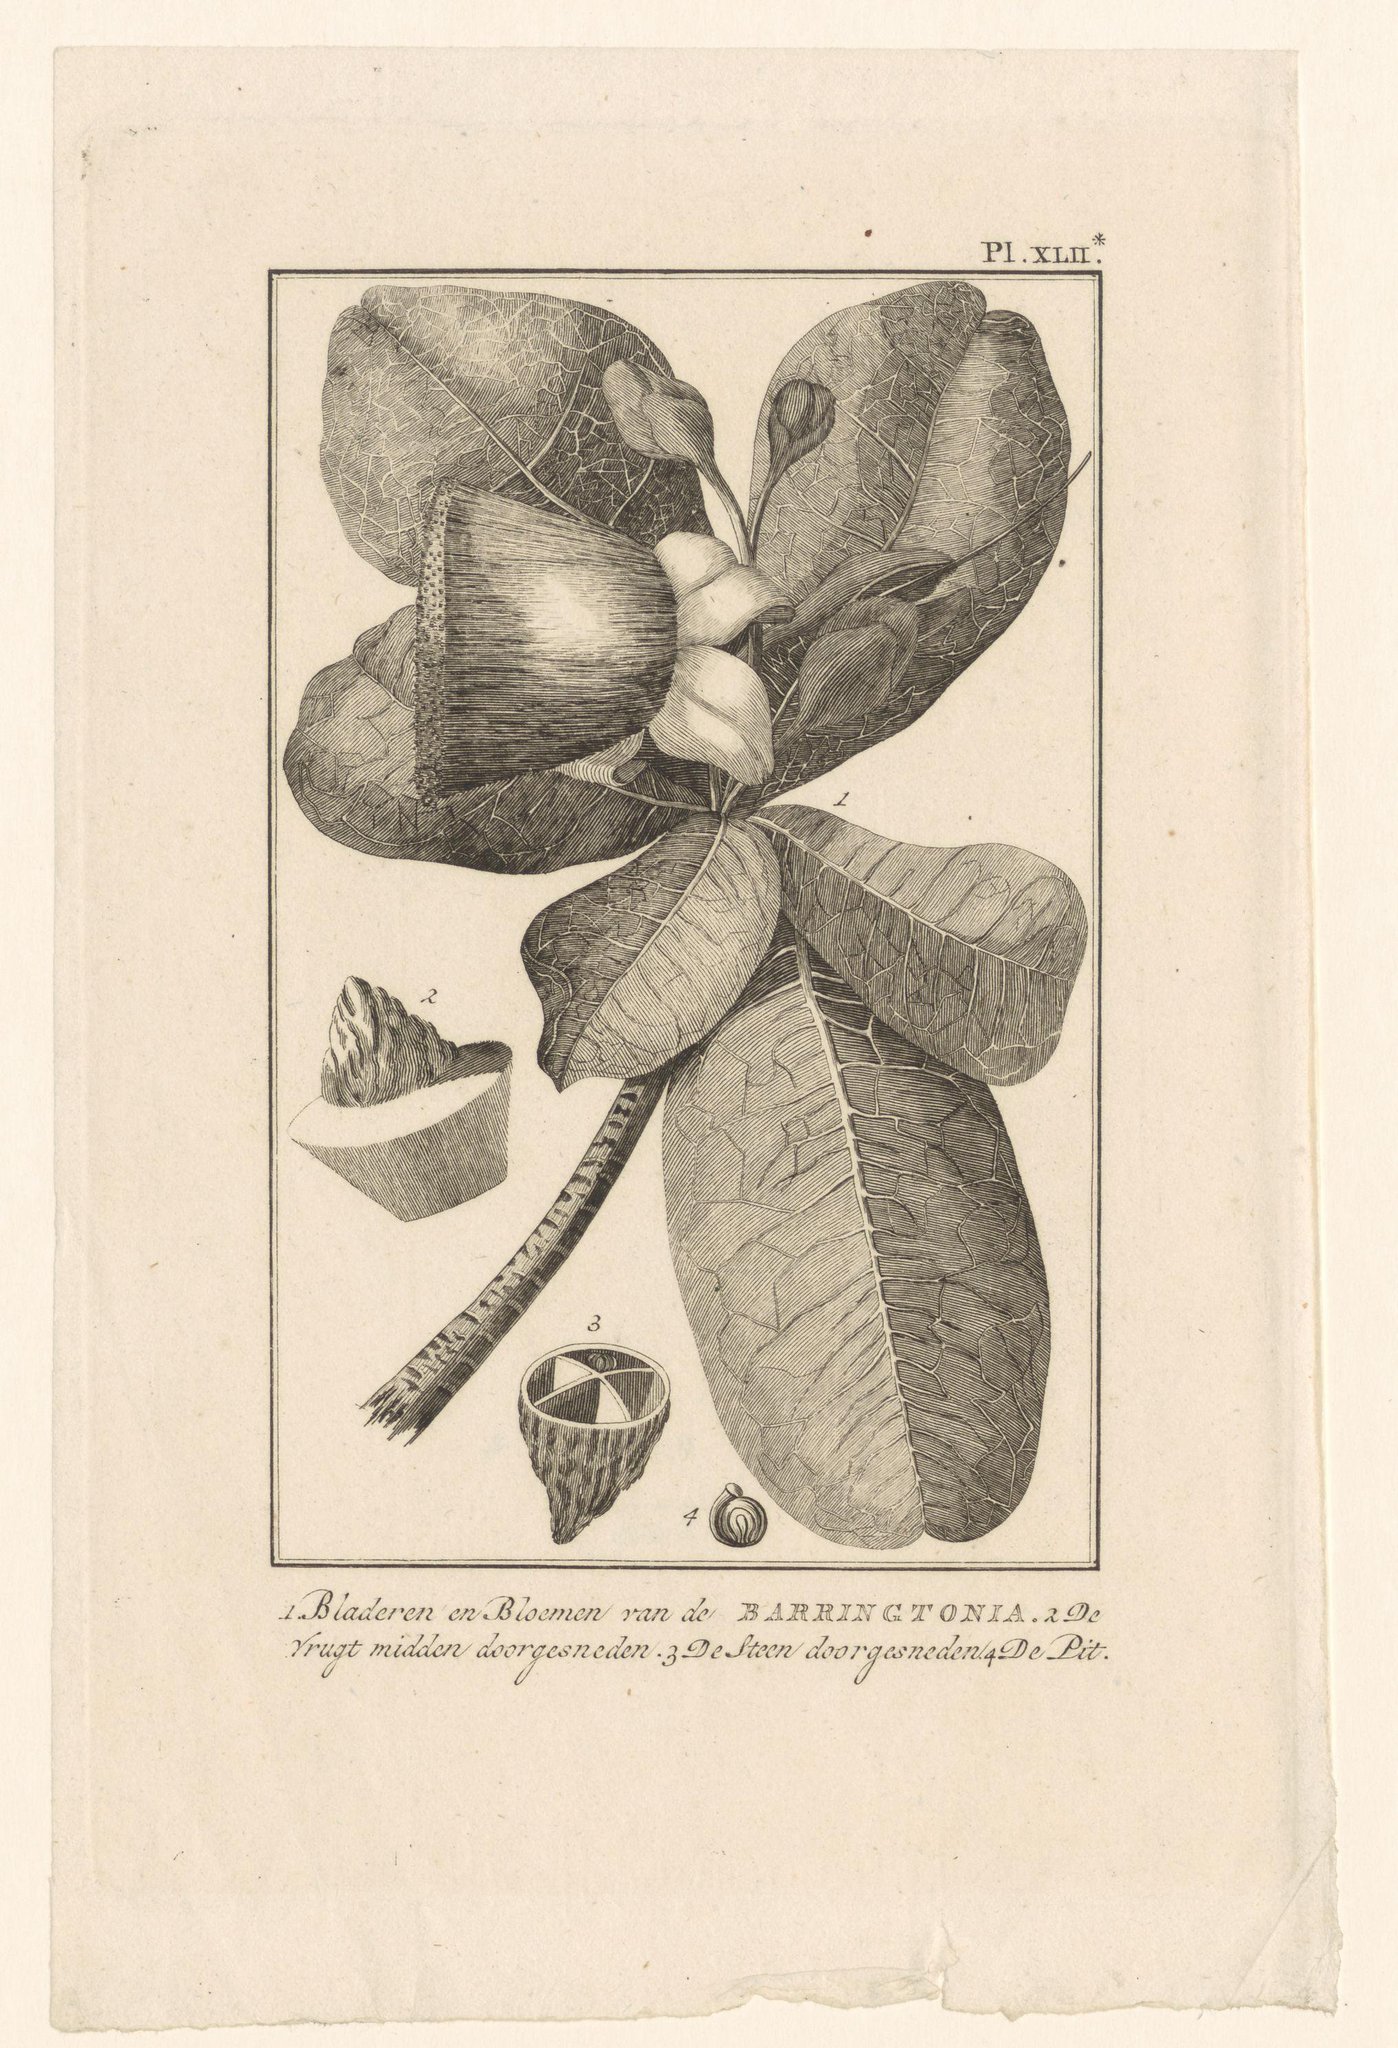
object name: book illustration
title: Barringtonia met vrucht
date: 1795-1803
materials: paper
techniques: engraving, etching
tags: trees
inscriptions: collector's mark: Lugt 2228, number: ‘XLII’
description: De prent is gebruikt in: Cook, James. Reize rondom de Waereld (...) met kaarten en plaaten. [Vertaald uit het Engels door] Jan David Pasteur. Leiden: Honkoop, Amsterdam: Allart, Den Haag: Van Cleef, 1795-1803, dl. 13.